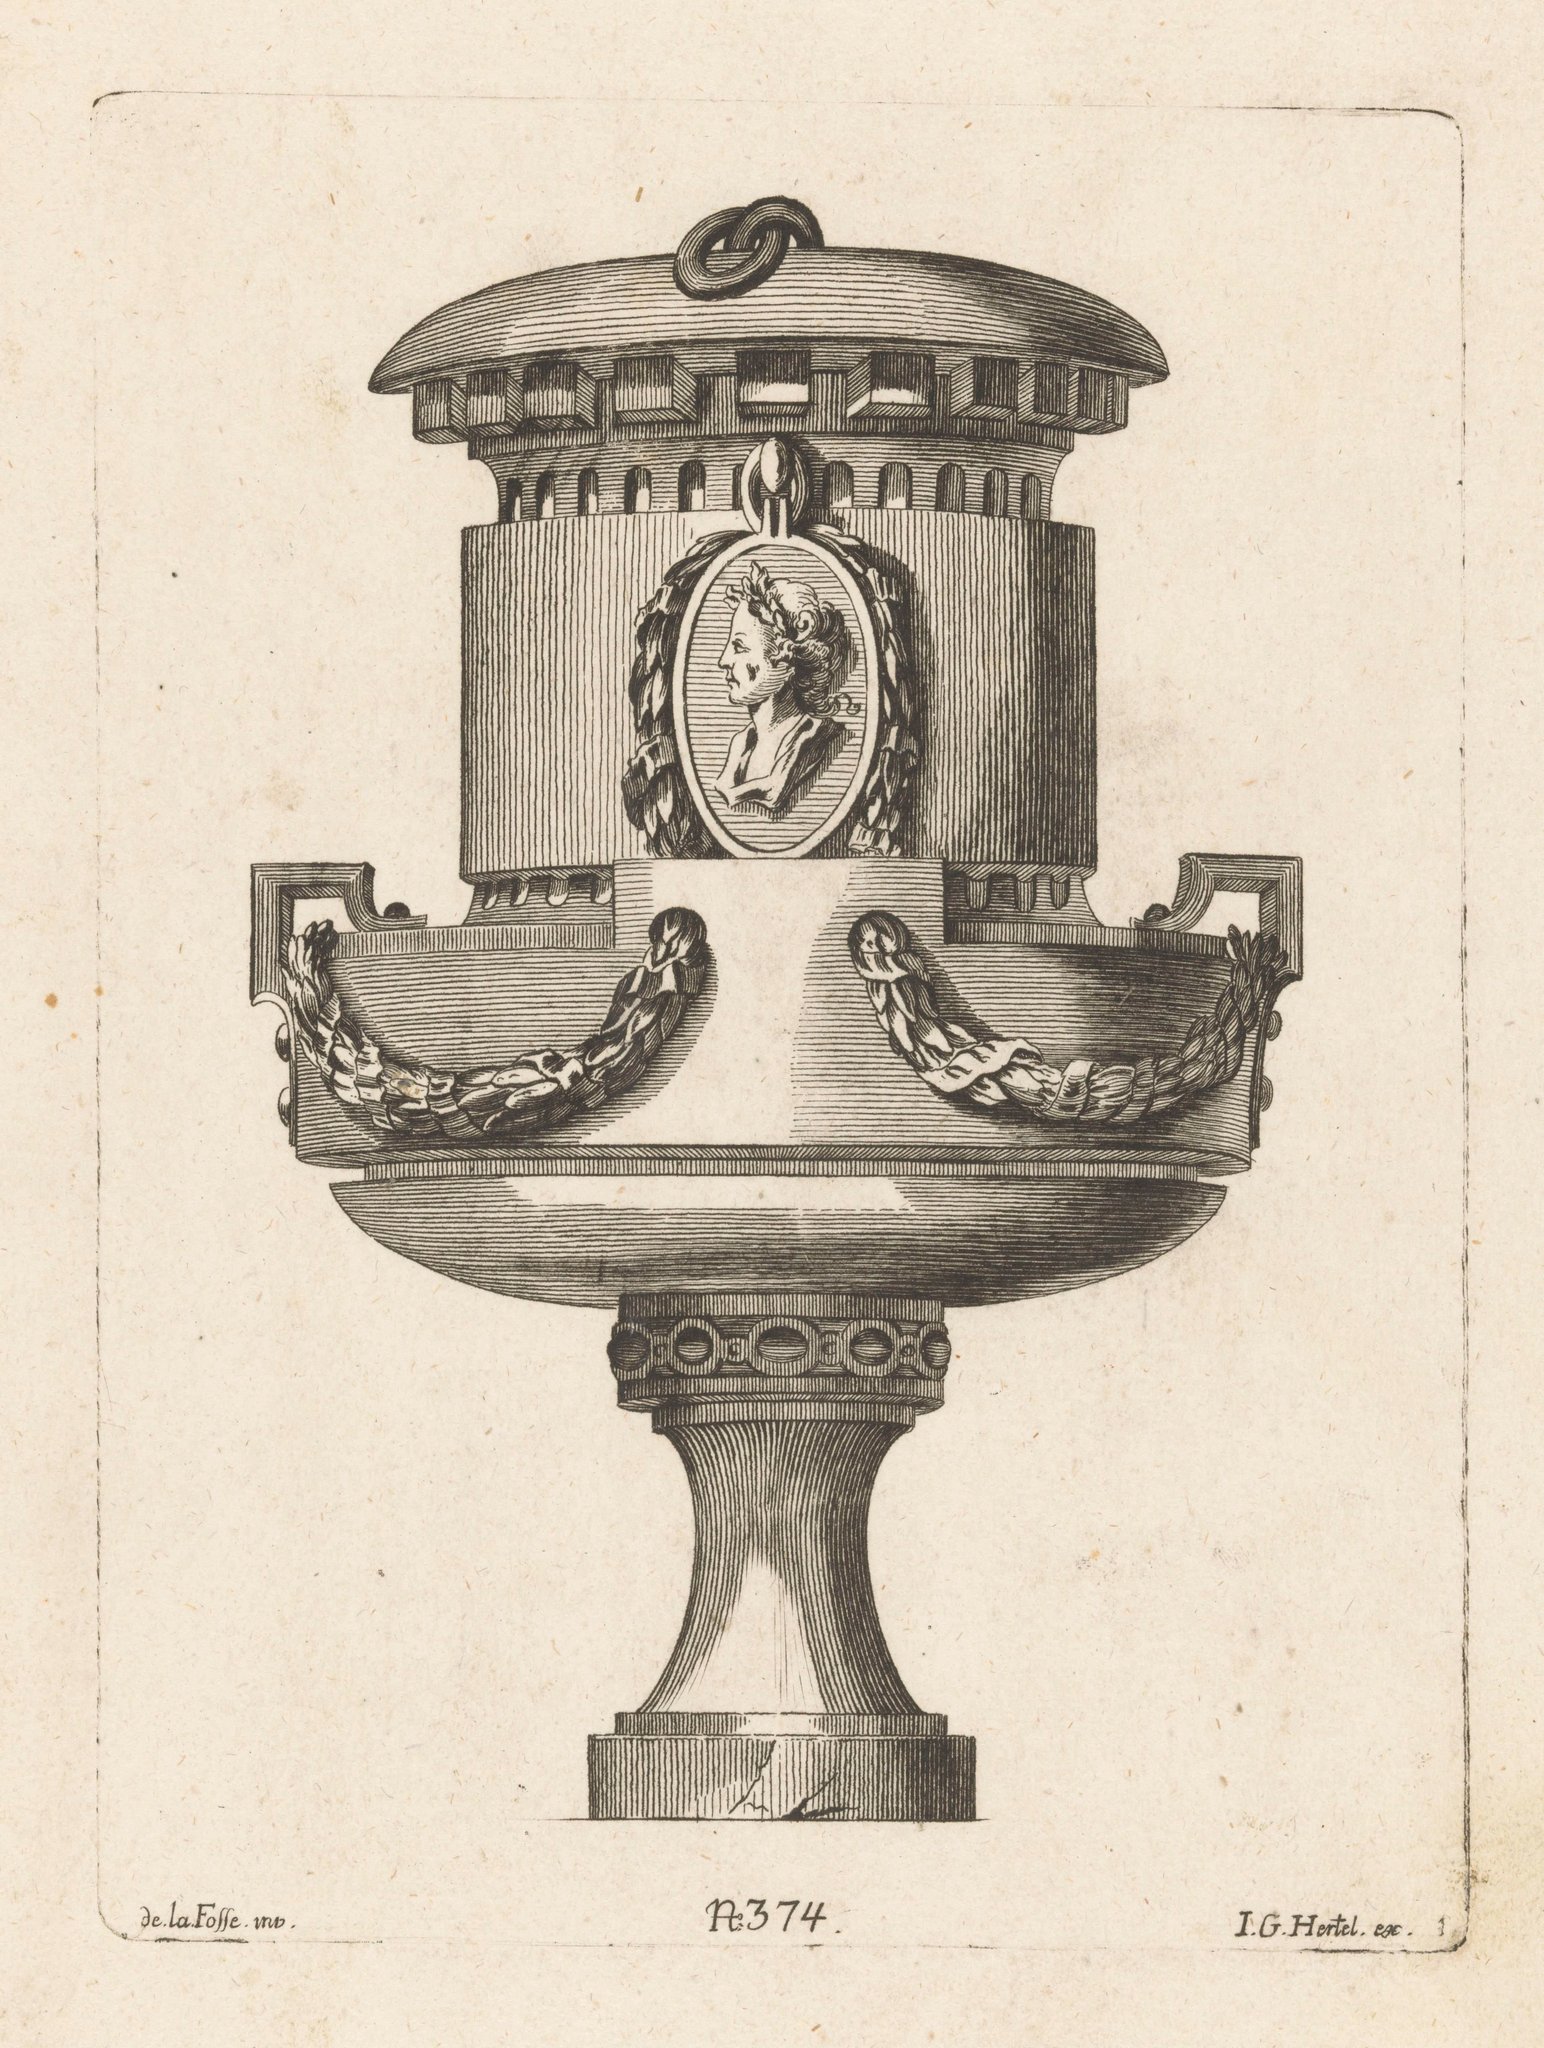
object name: ornament print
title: Vaas met medaillon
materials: paper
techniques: engraving, etching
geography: germany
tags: vase ~ ornament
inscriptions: collector's mark: Lugt 2228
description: Een geornamenteerde vaas met een ovaal medaillon met vrouwenportret en profil en guirlandes. Uitgeversnummer 374.